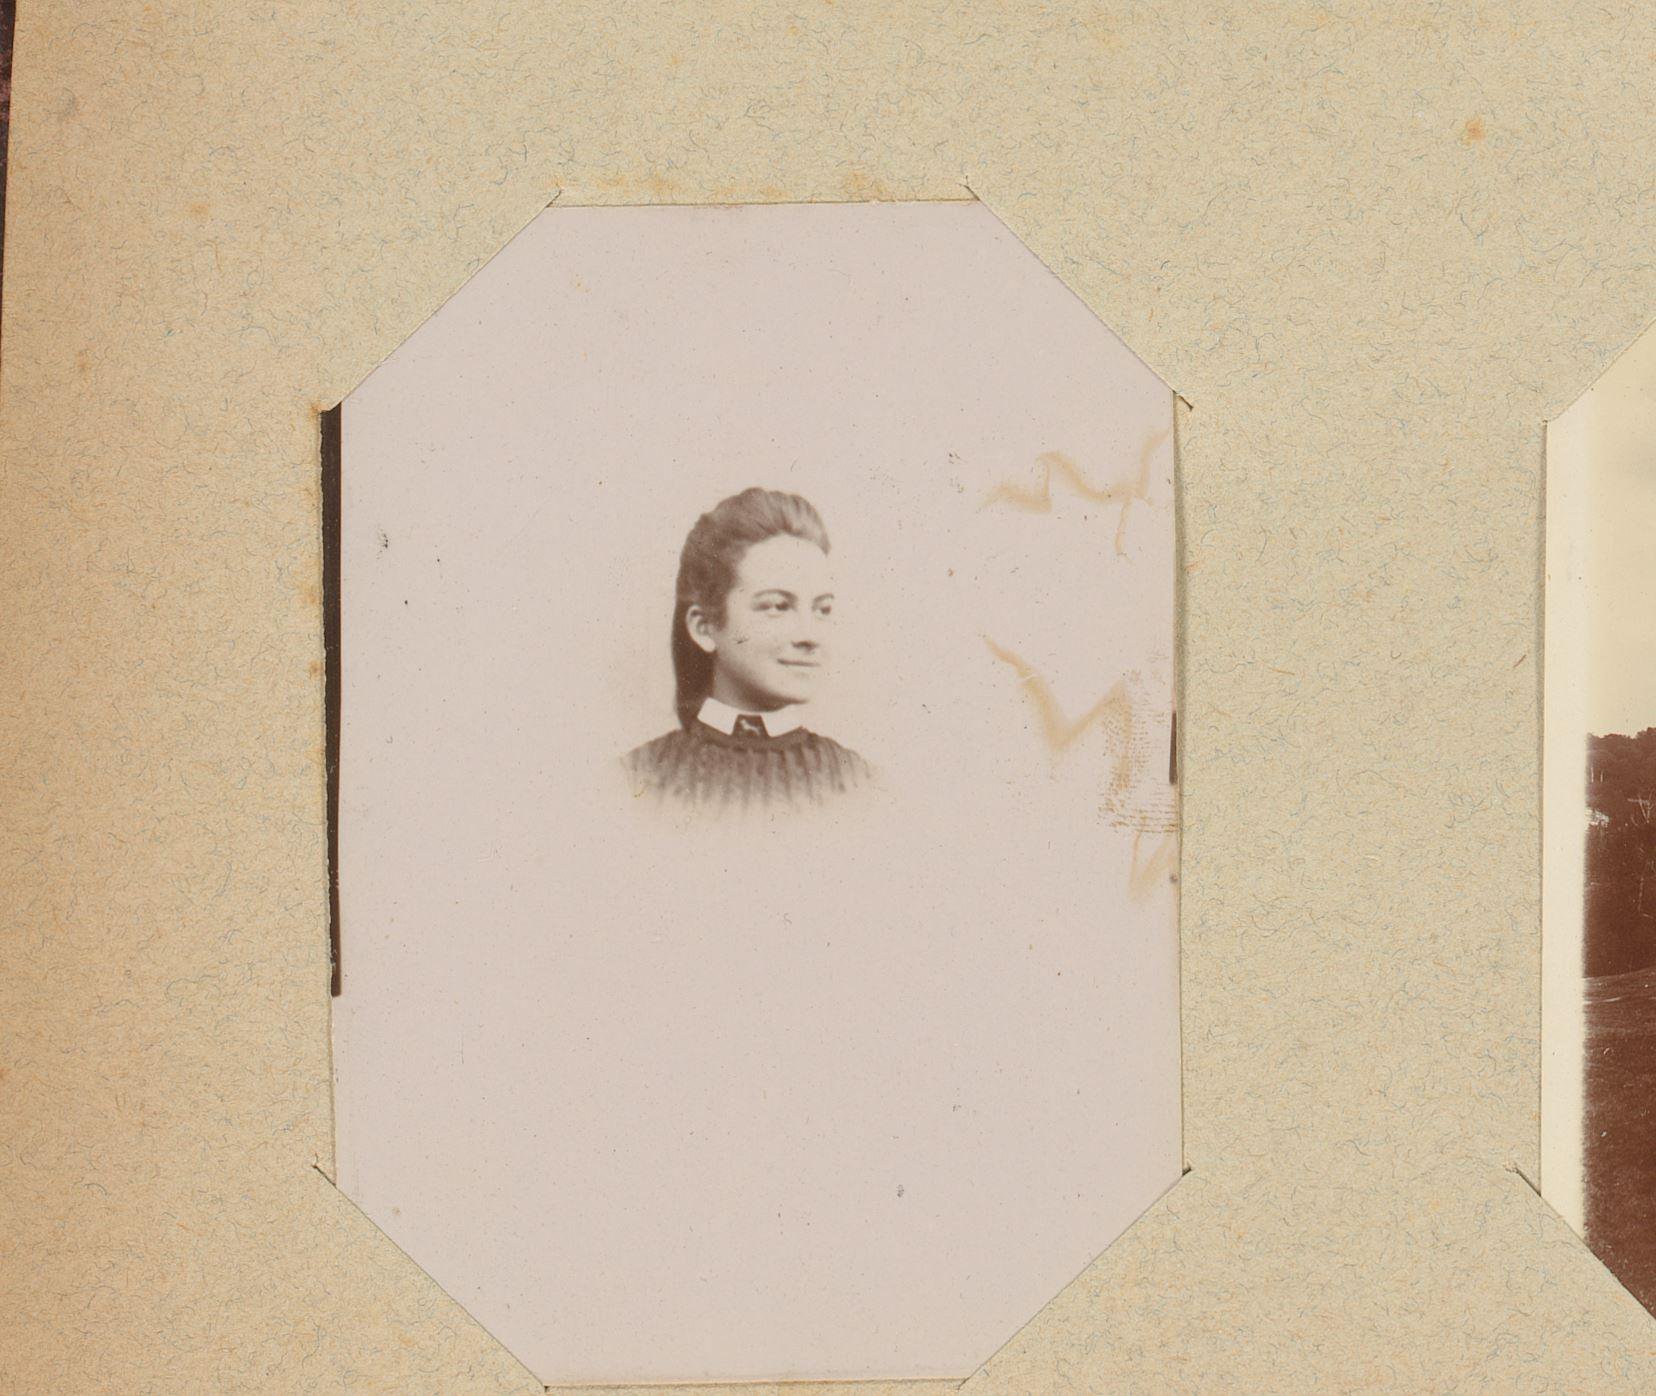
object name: album leaf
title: Portret van een jonge vrouw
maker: Anonymous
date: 1897-1900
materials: paper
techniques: gelatin silver print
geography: france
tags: adolescent, young woman, maiden, historical persons, france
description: Over de foto is een ander negatief afgedrukt van een voorstelling van bomen.